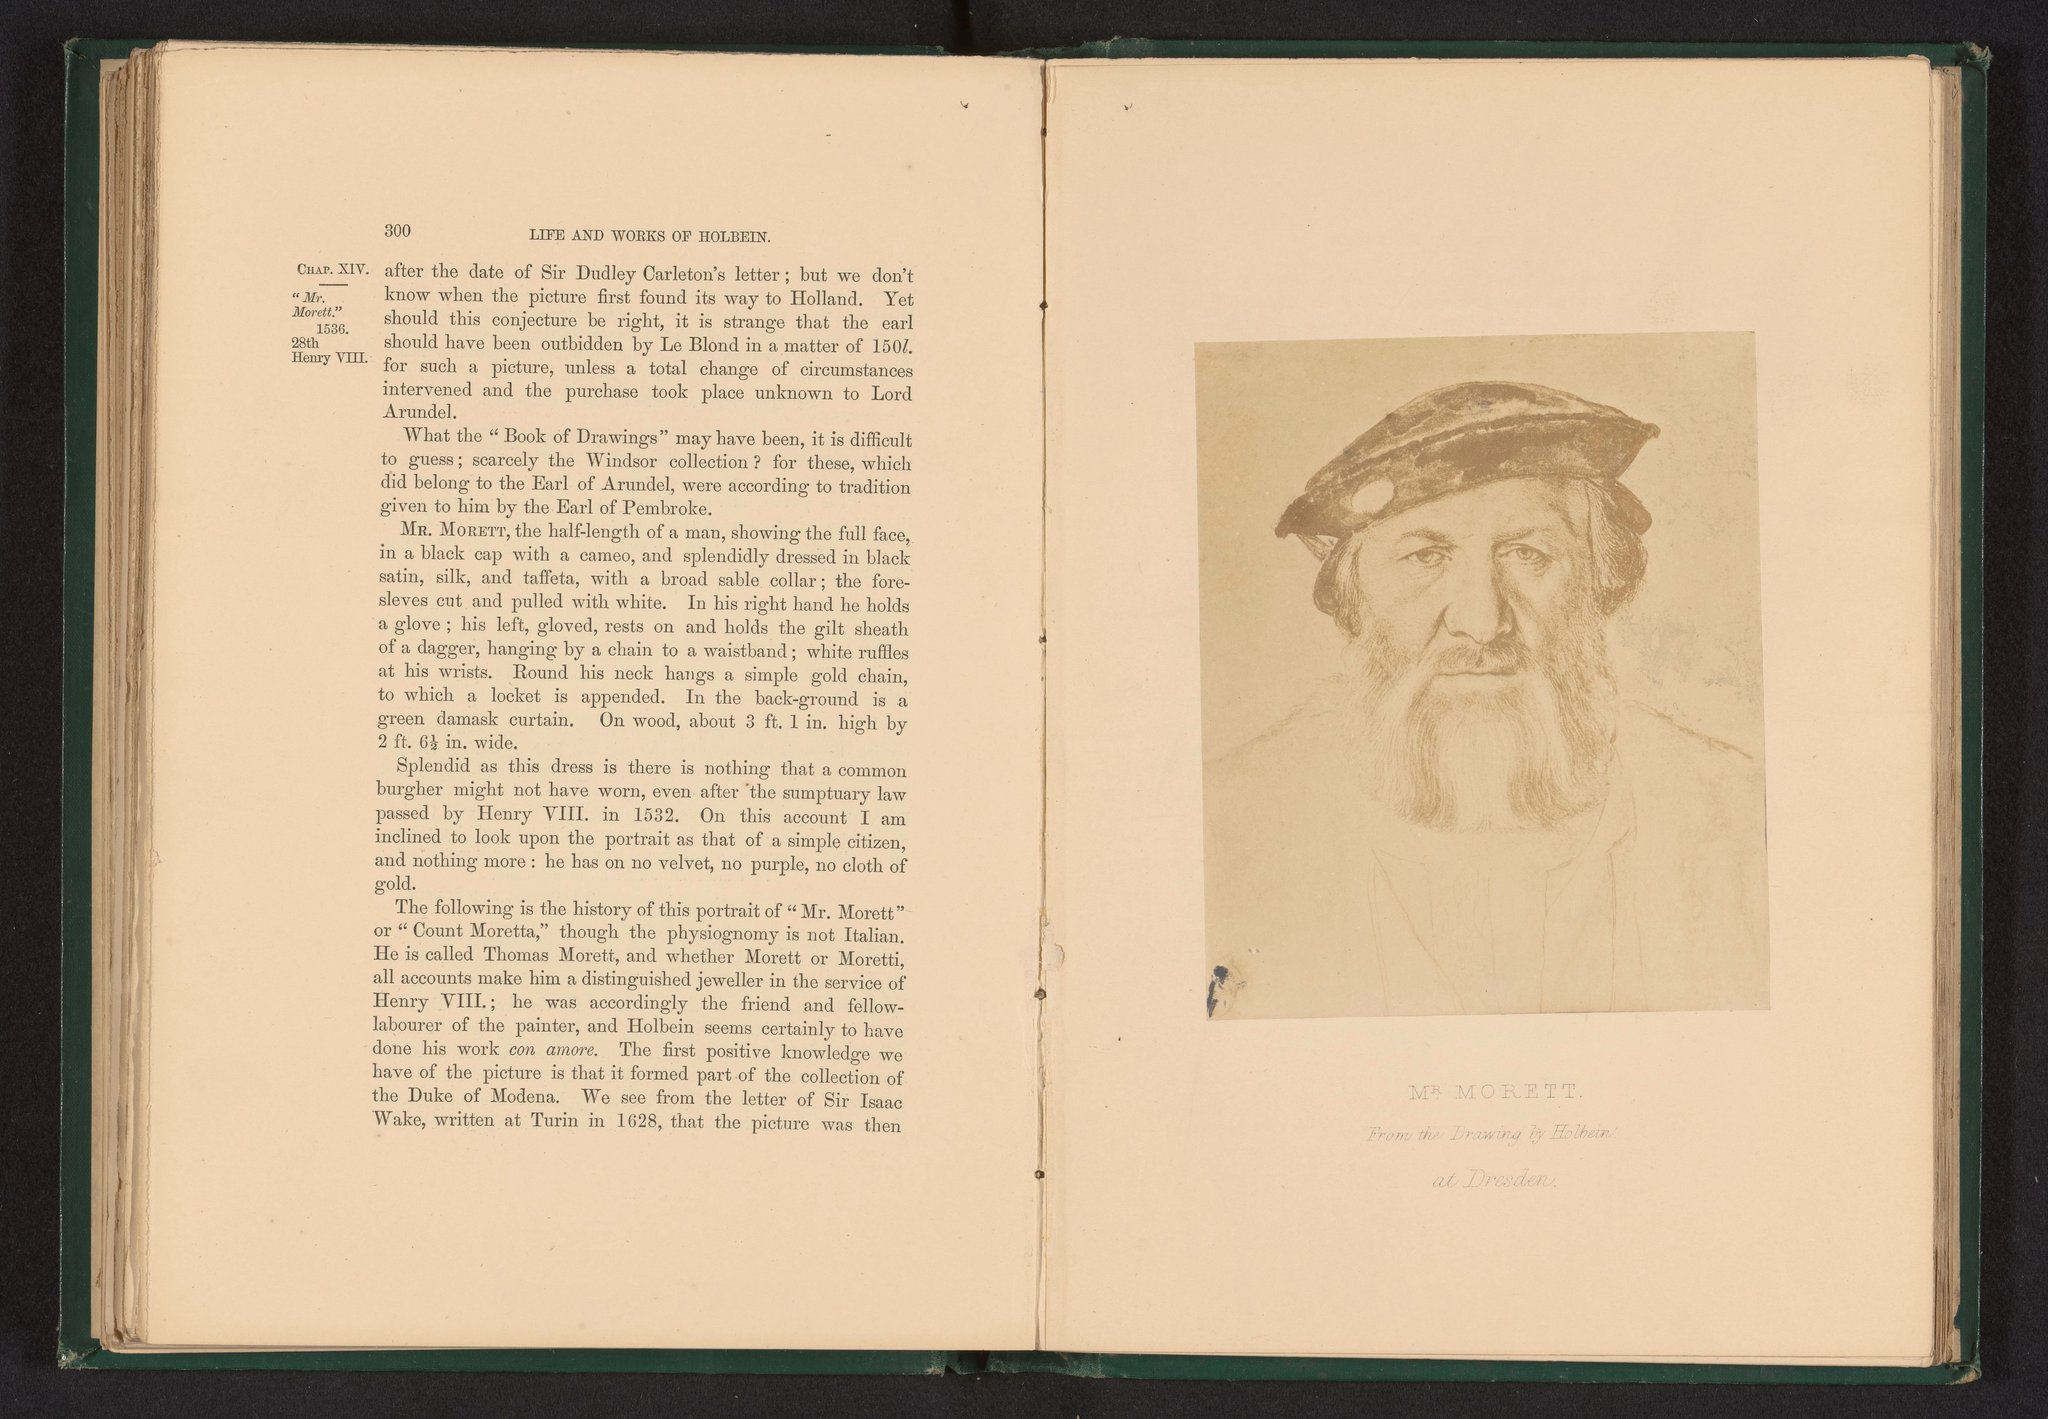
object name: photograph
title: Mr. Morrett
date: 1857-1867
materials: photographic support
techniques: albumen print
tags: diplomacy, diplomat